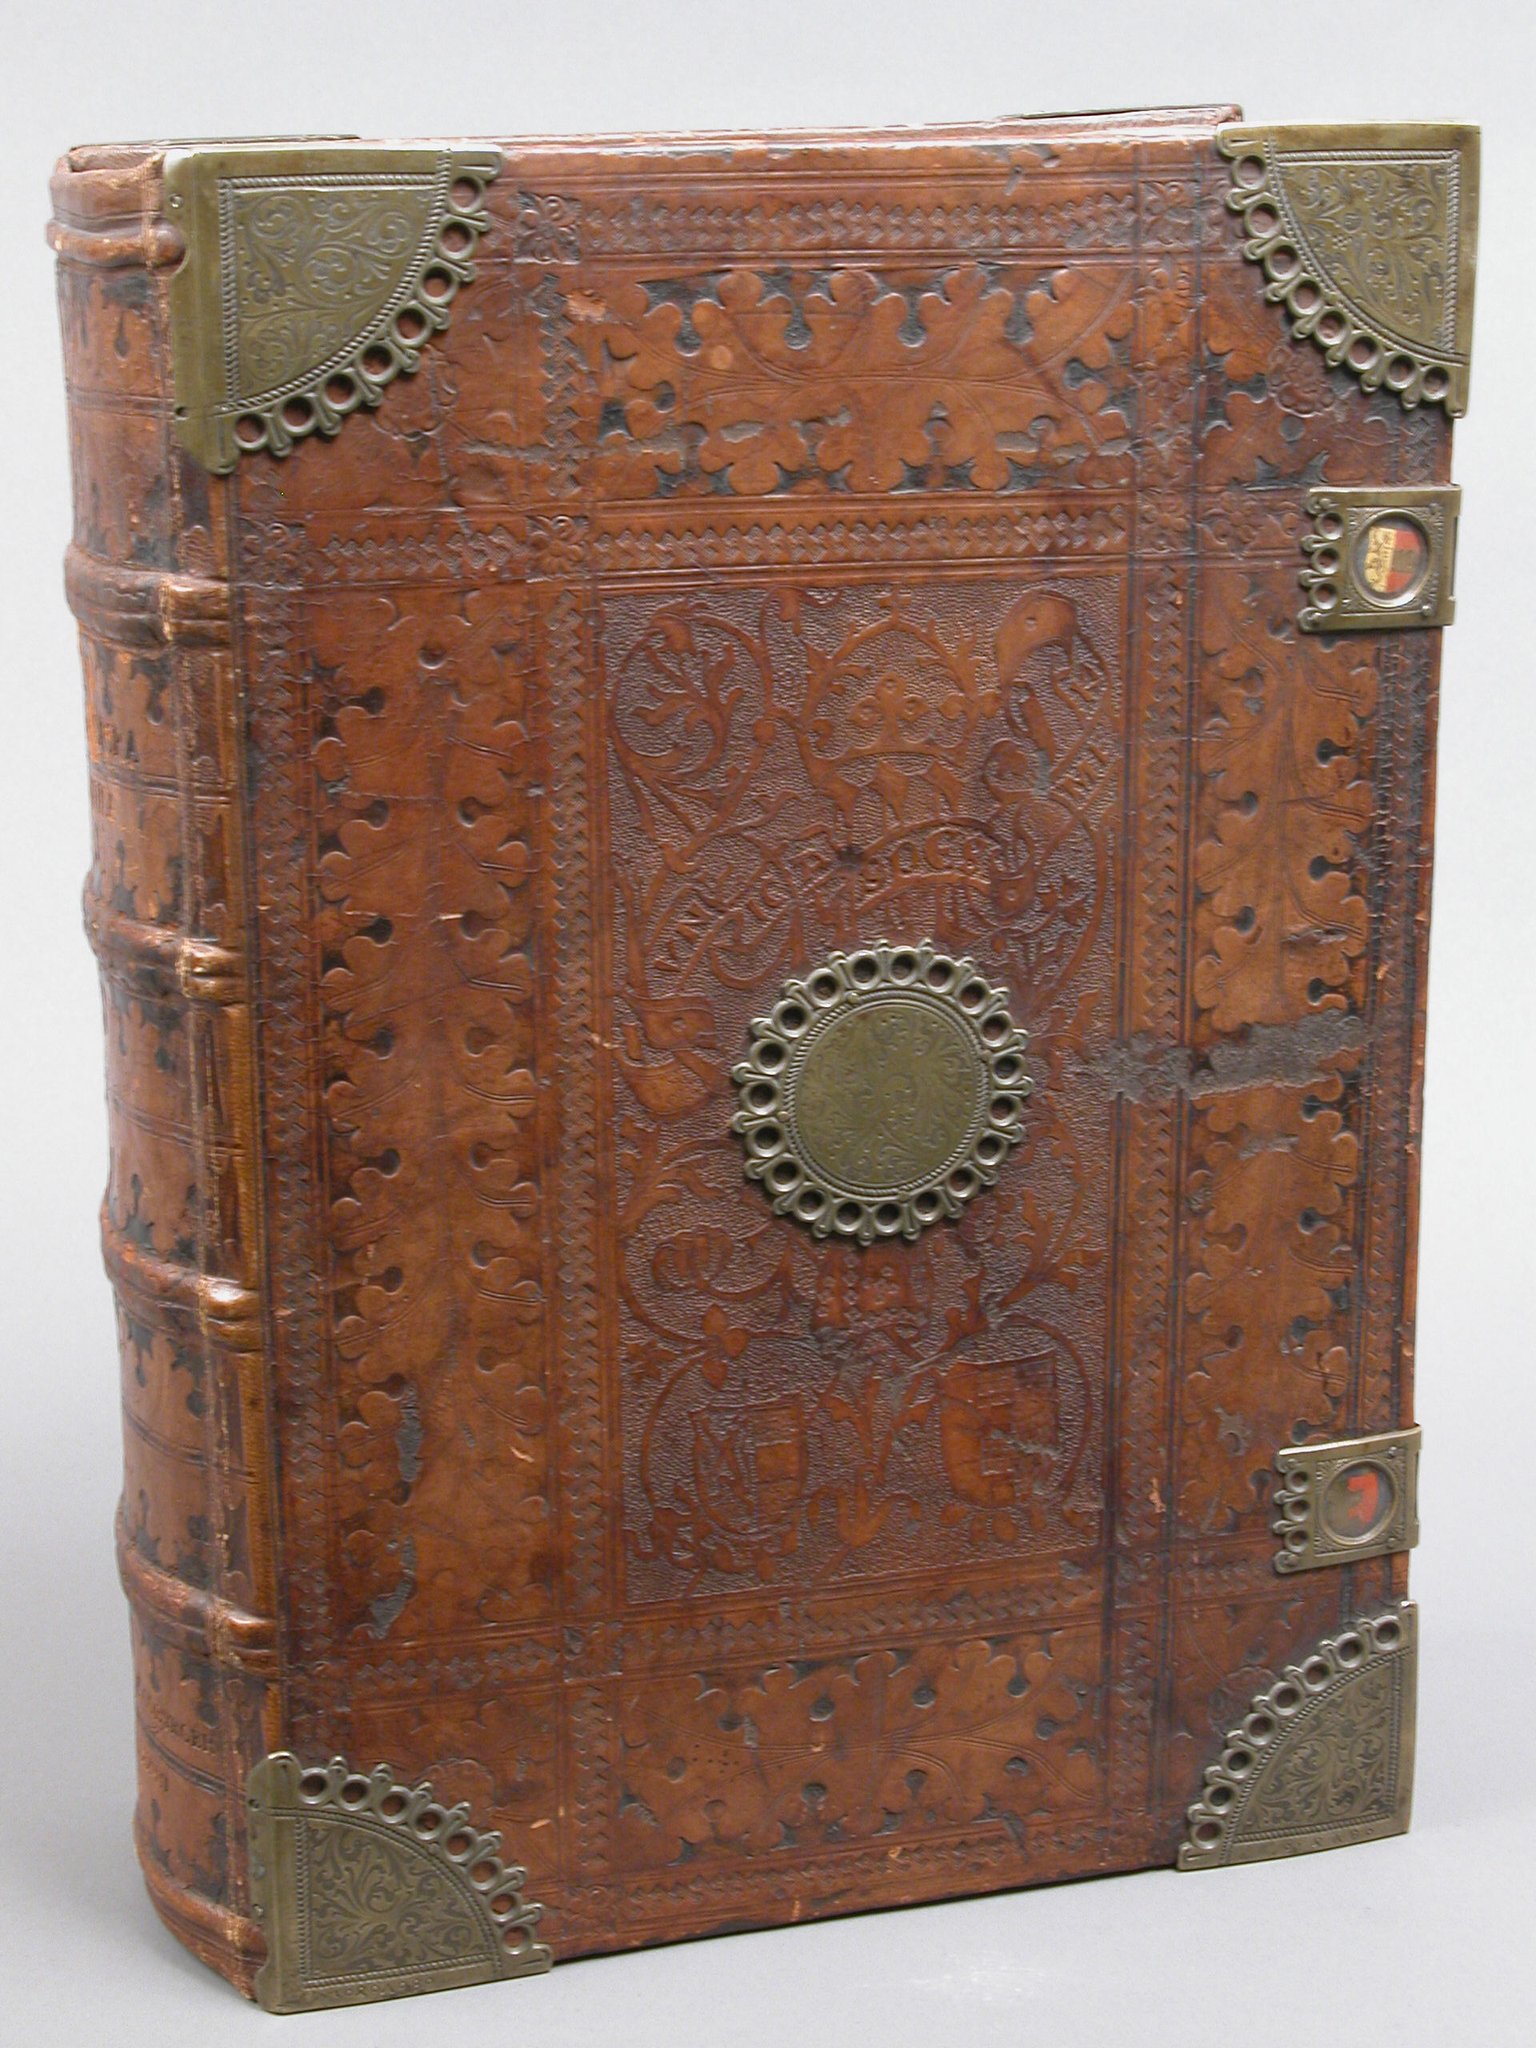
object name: book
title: Bible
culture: german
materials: brass, gold, ink, leather, metal leaf, paper, shell, paint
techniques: bookbinding, engraving, hand coloring, printing, stamping, tooling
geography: germany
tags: coat of arms